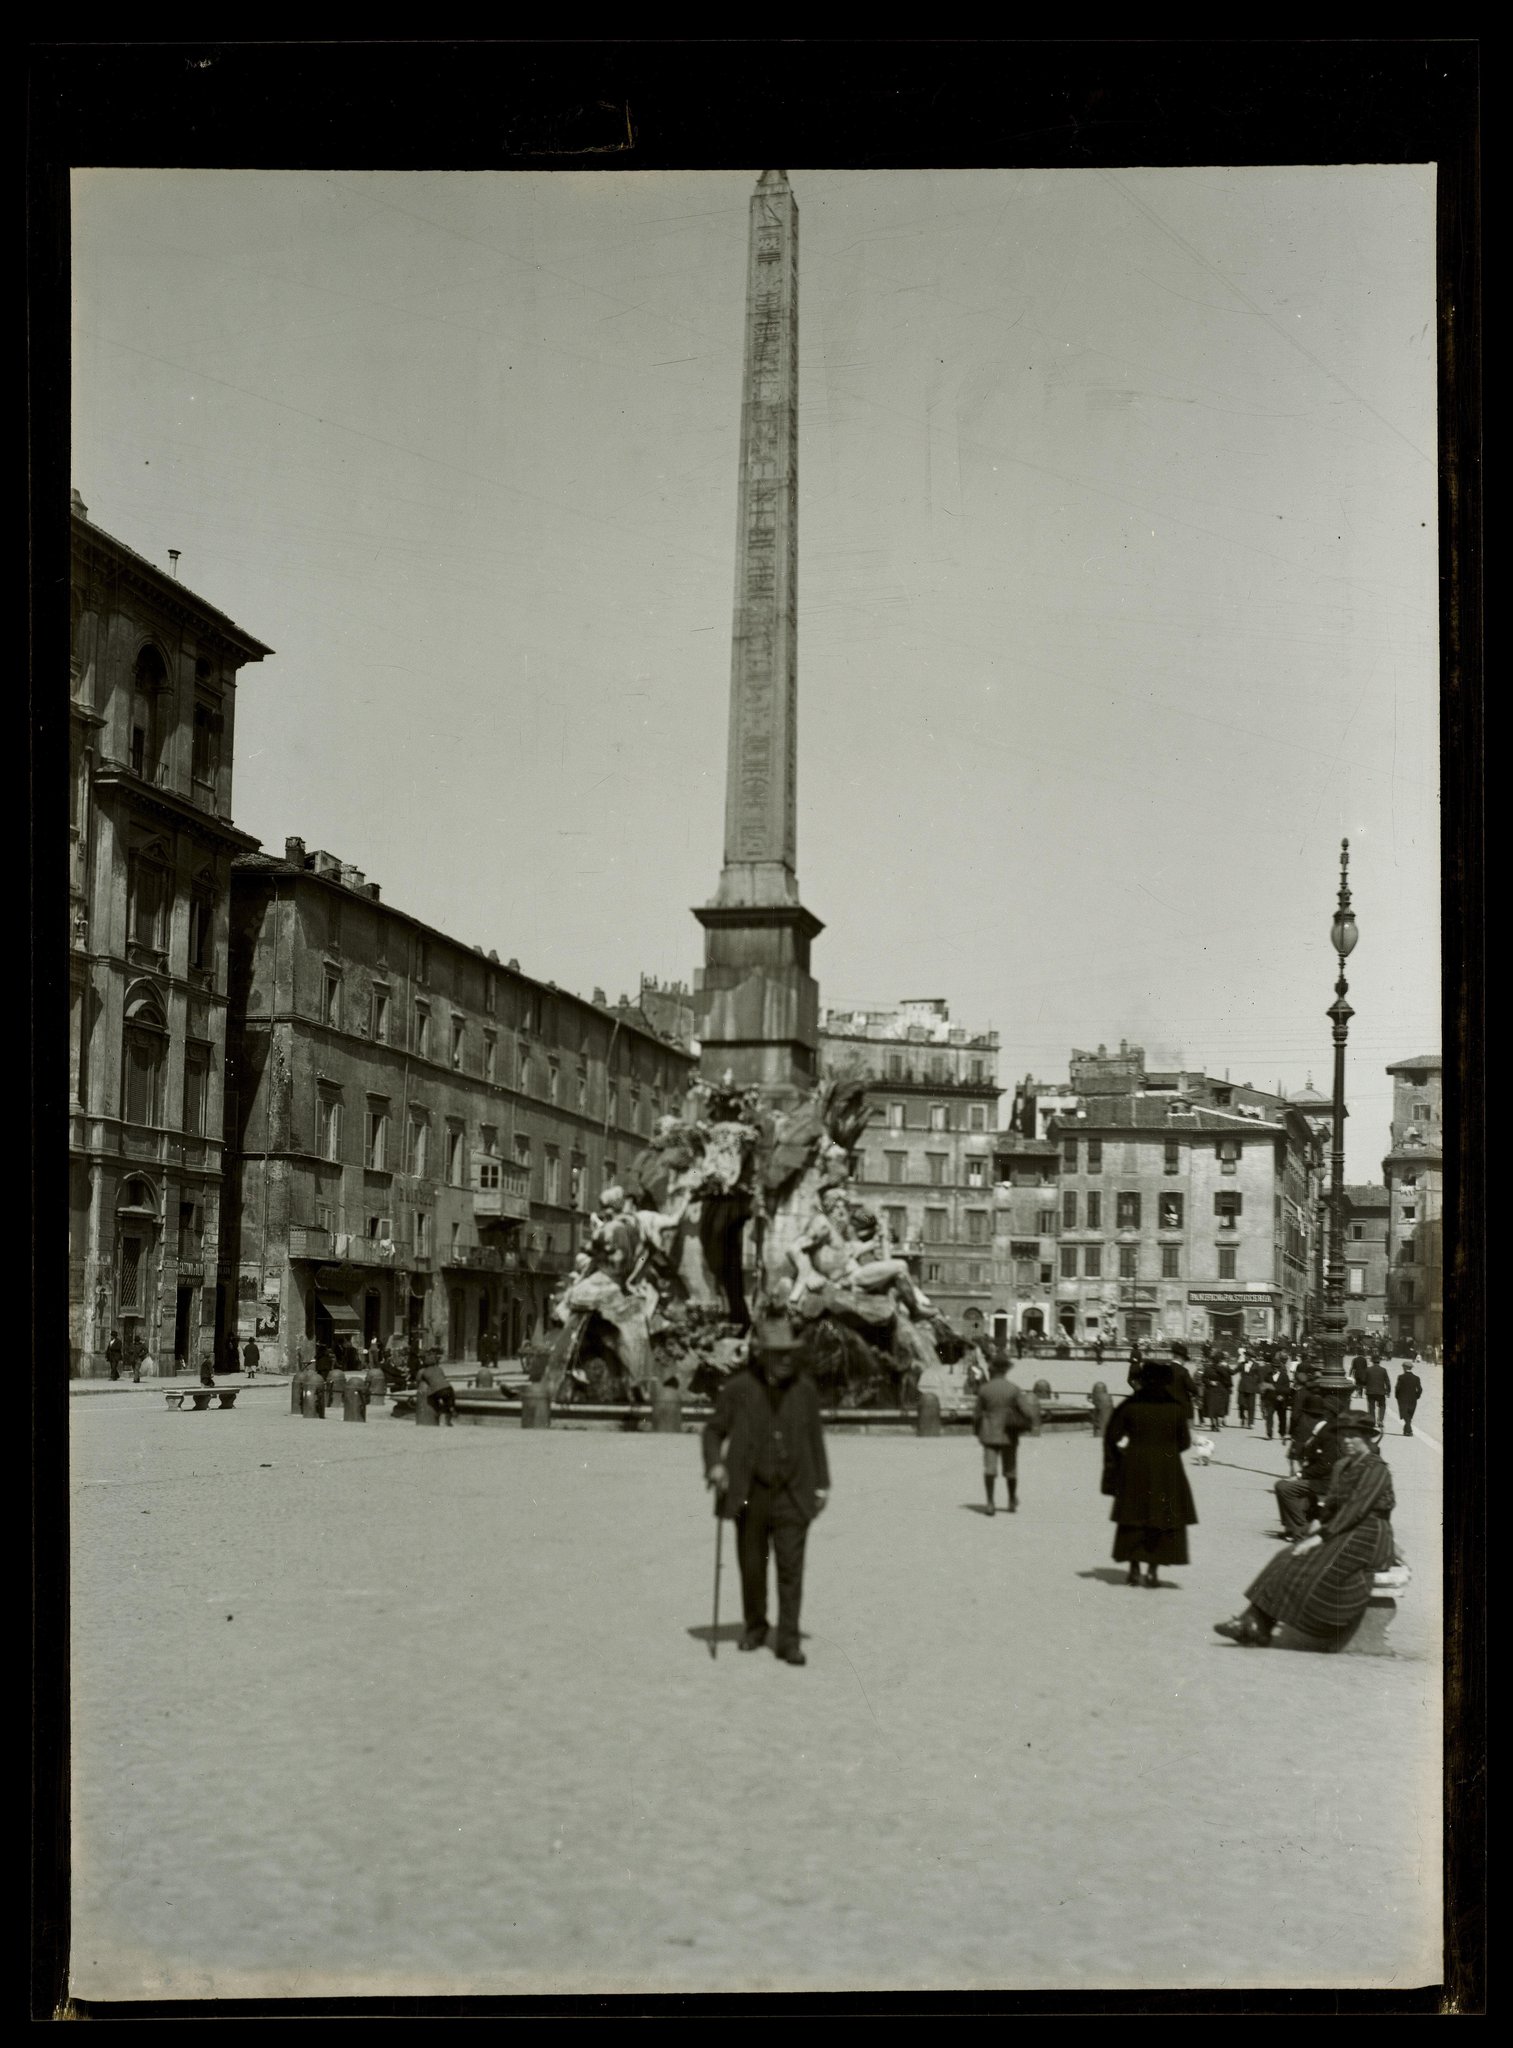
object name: photograph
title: Filmnegatief met opname van Rome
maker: Anonymous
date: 1907-1935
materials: film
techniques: gelatin silver negative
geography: rome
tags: rome